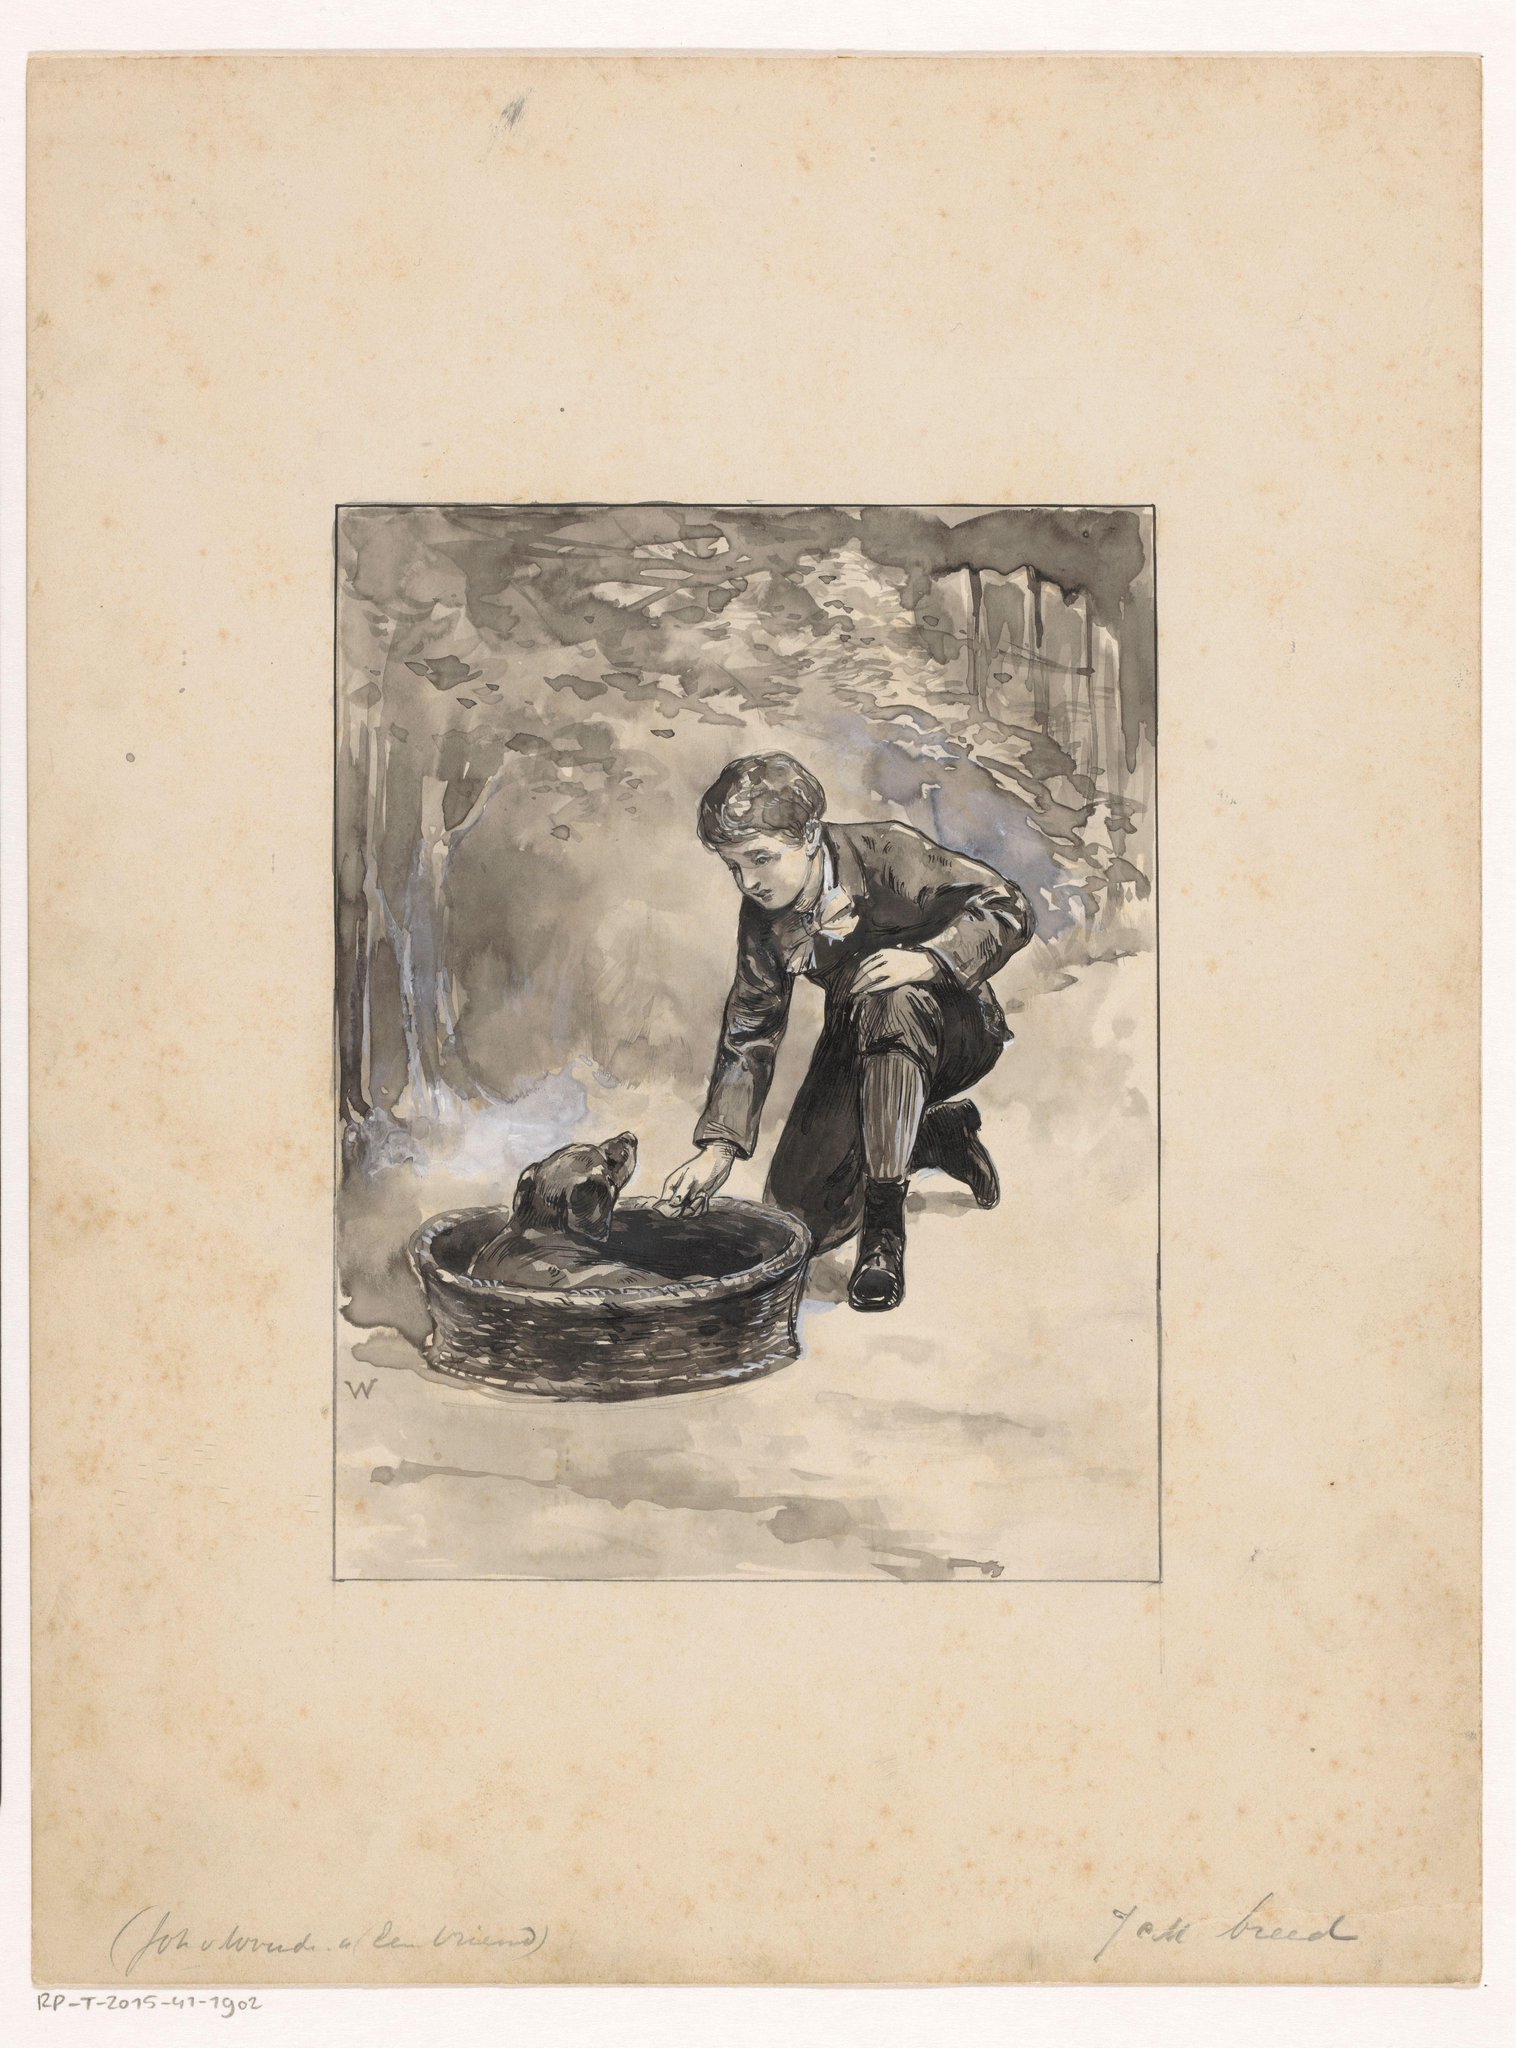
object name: boekillustratie ontwerp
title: Jongen knielt bij een hond in een mand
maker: willem wenckebach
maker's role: designer, draughtsman, painter, print maker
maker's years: 1860-1937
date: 1870-1937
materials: cardboard, paint, ink, watercolor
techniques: brush, pen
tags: boy (child between toddler and youth), dog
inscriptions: monogram: ‘W’, annotation: ‘(Joh v. Woude Een vriend)’, :, collector's mark: Lugt 2228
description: De jongen heeft een voorwerp voor de hond in zijn hand. In de achtergrond bomen.